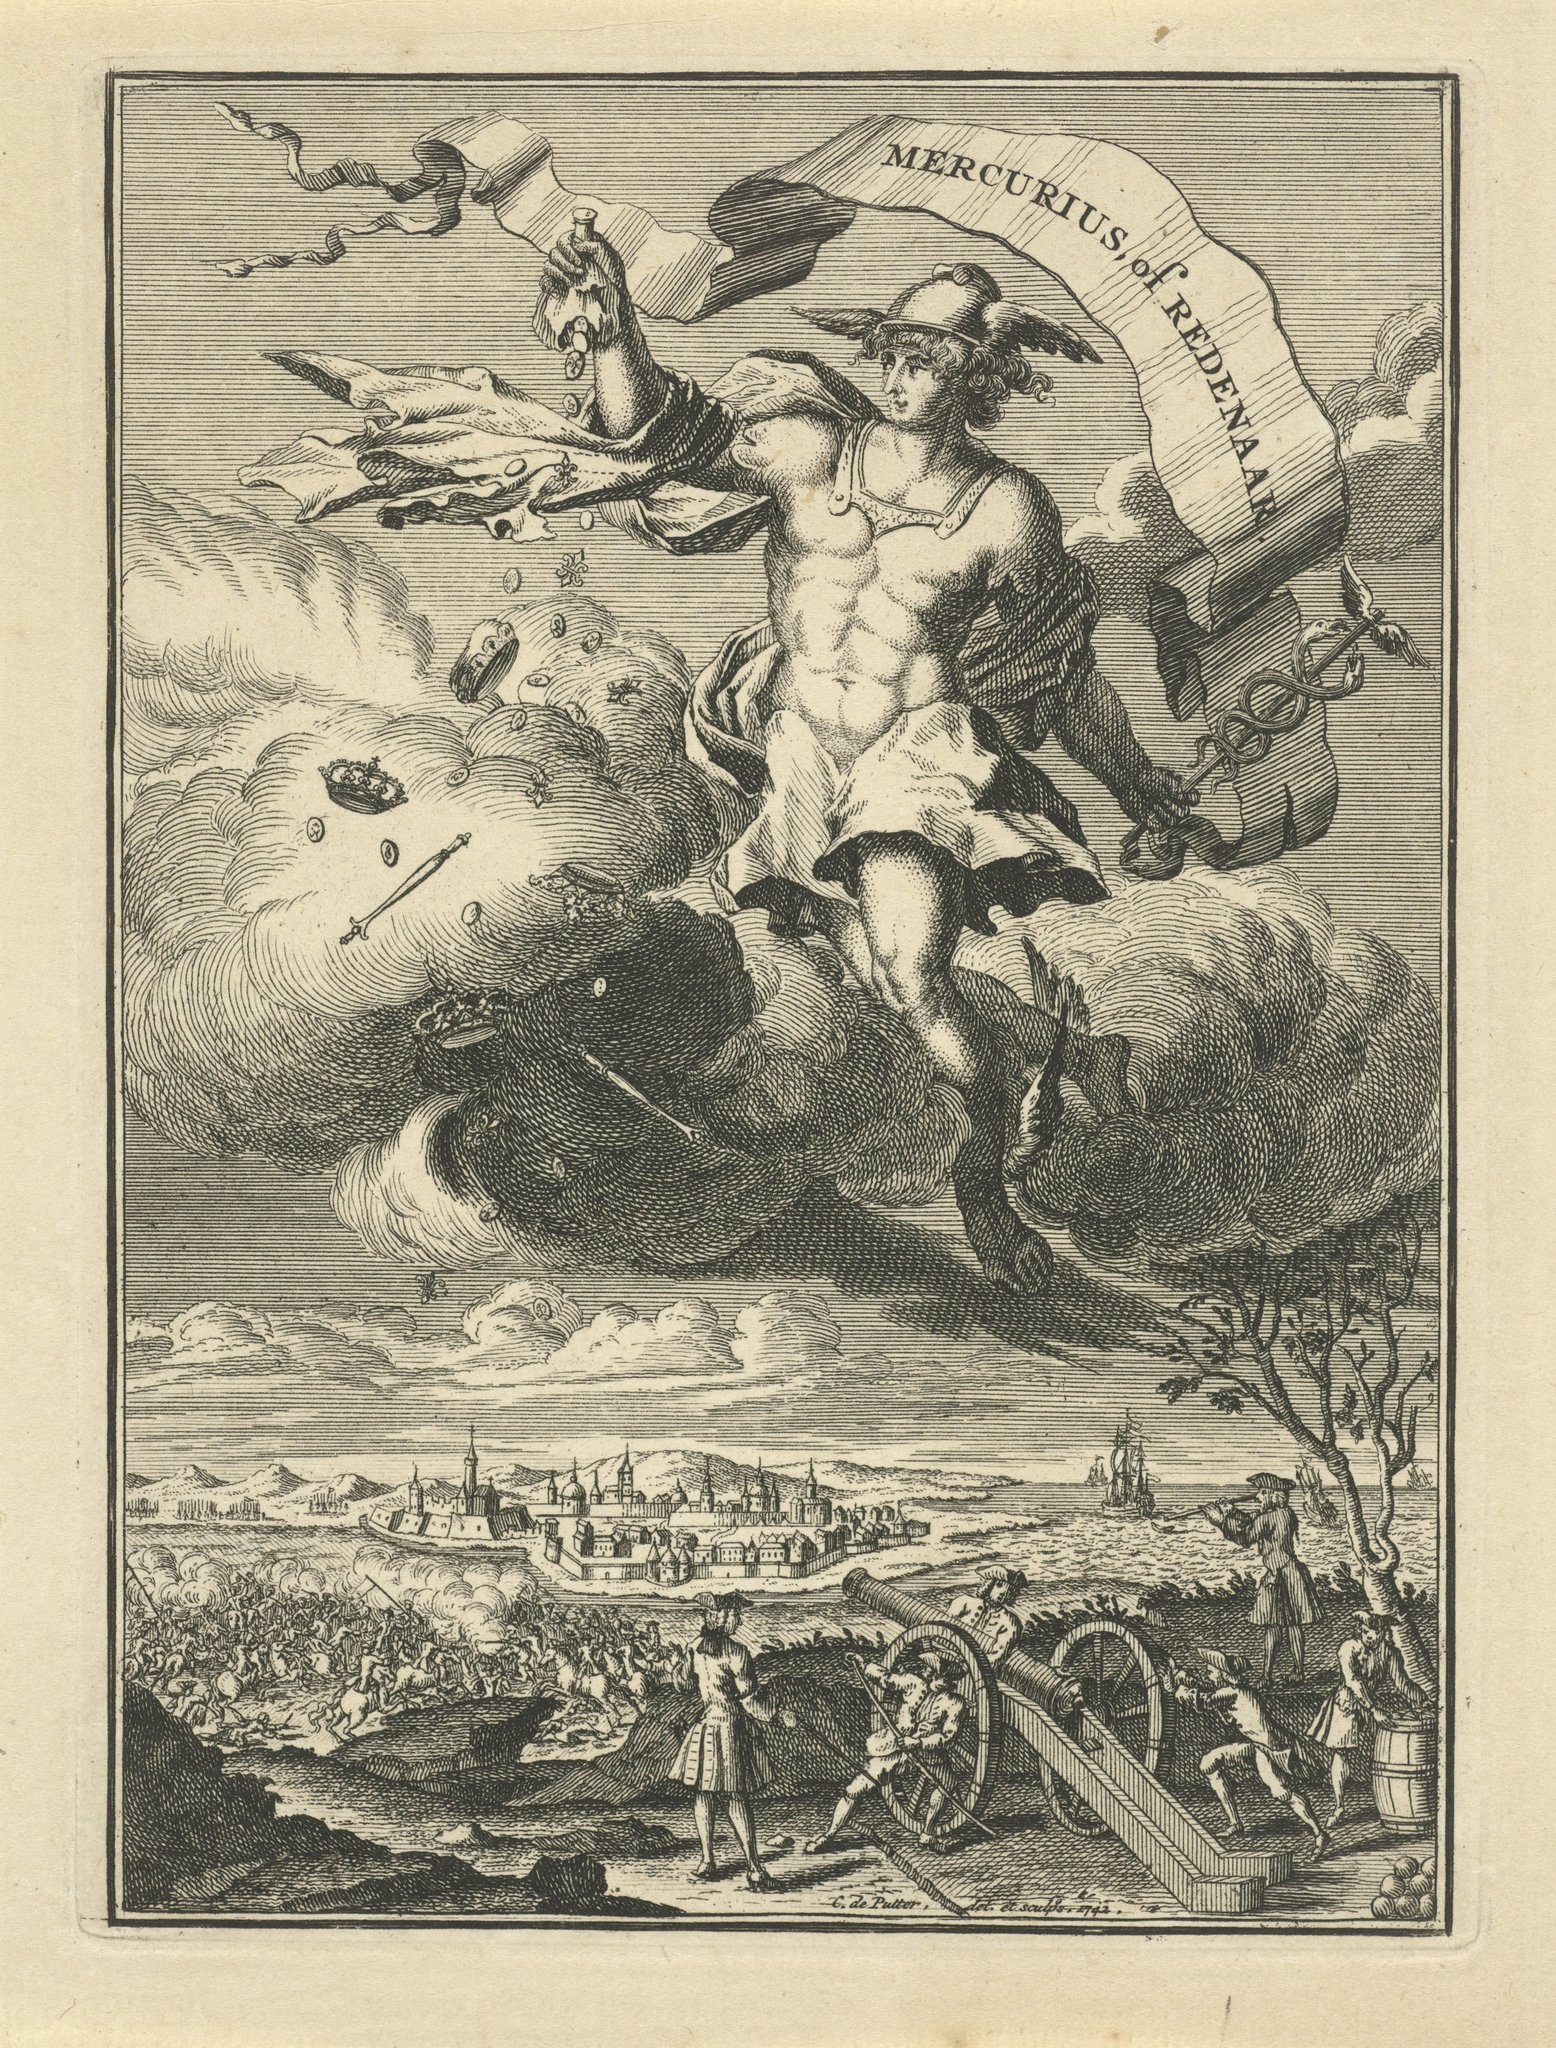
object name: titelblad, titelpagina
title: Titelpagina van Mercurius of redenaar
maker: coenraad de putter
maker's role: print maker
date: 1742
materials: paper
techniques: engraving, etching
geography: netherlands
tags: purse, money-bag, (story of) mercury (hermes), battle, attributes of mercury, siege, money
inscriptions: collector's mark: Lugt 2228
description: Titelpagina van 'Mercurius of redenaar', met een zwevende Mercurius, die een gescheurde geldbundel uitstrooit over het slagveld onder hem. Op de achtergrond een vestingsstad en de zee.